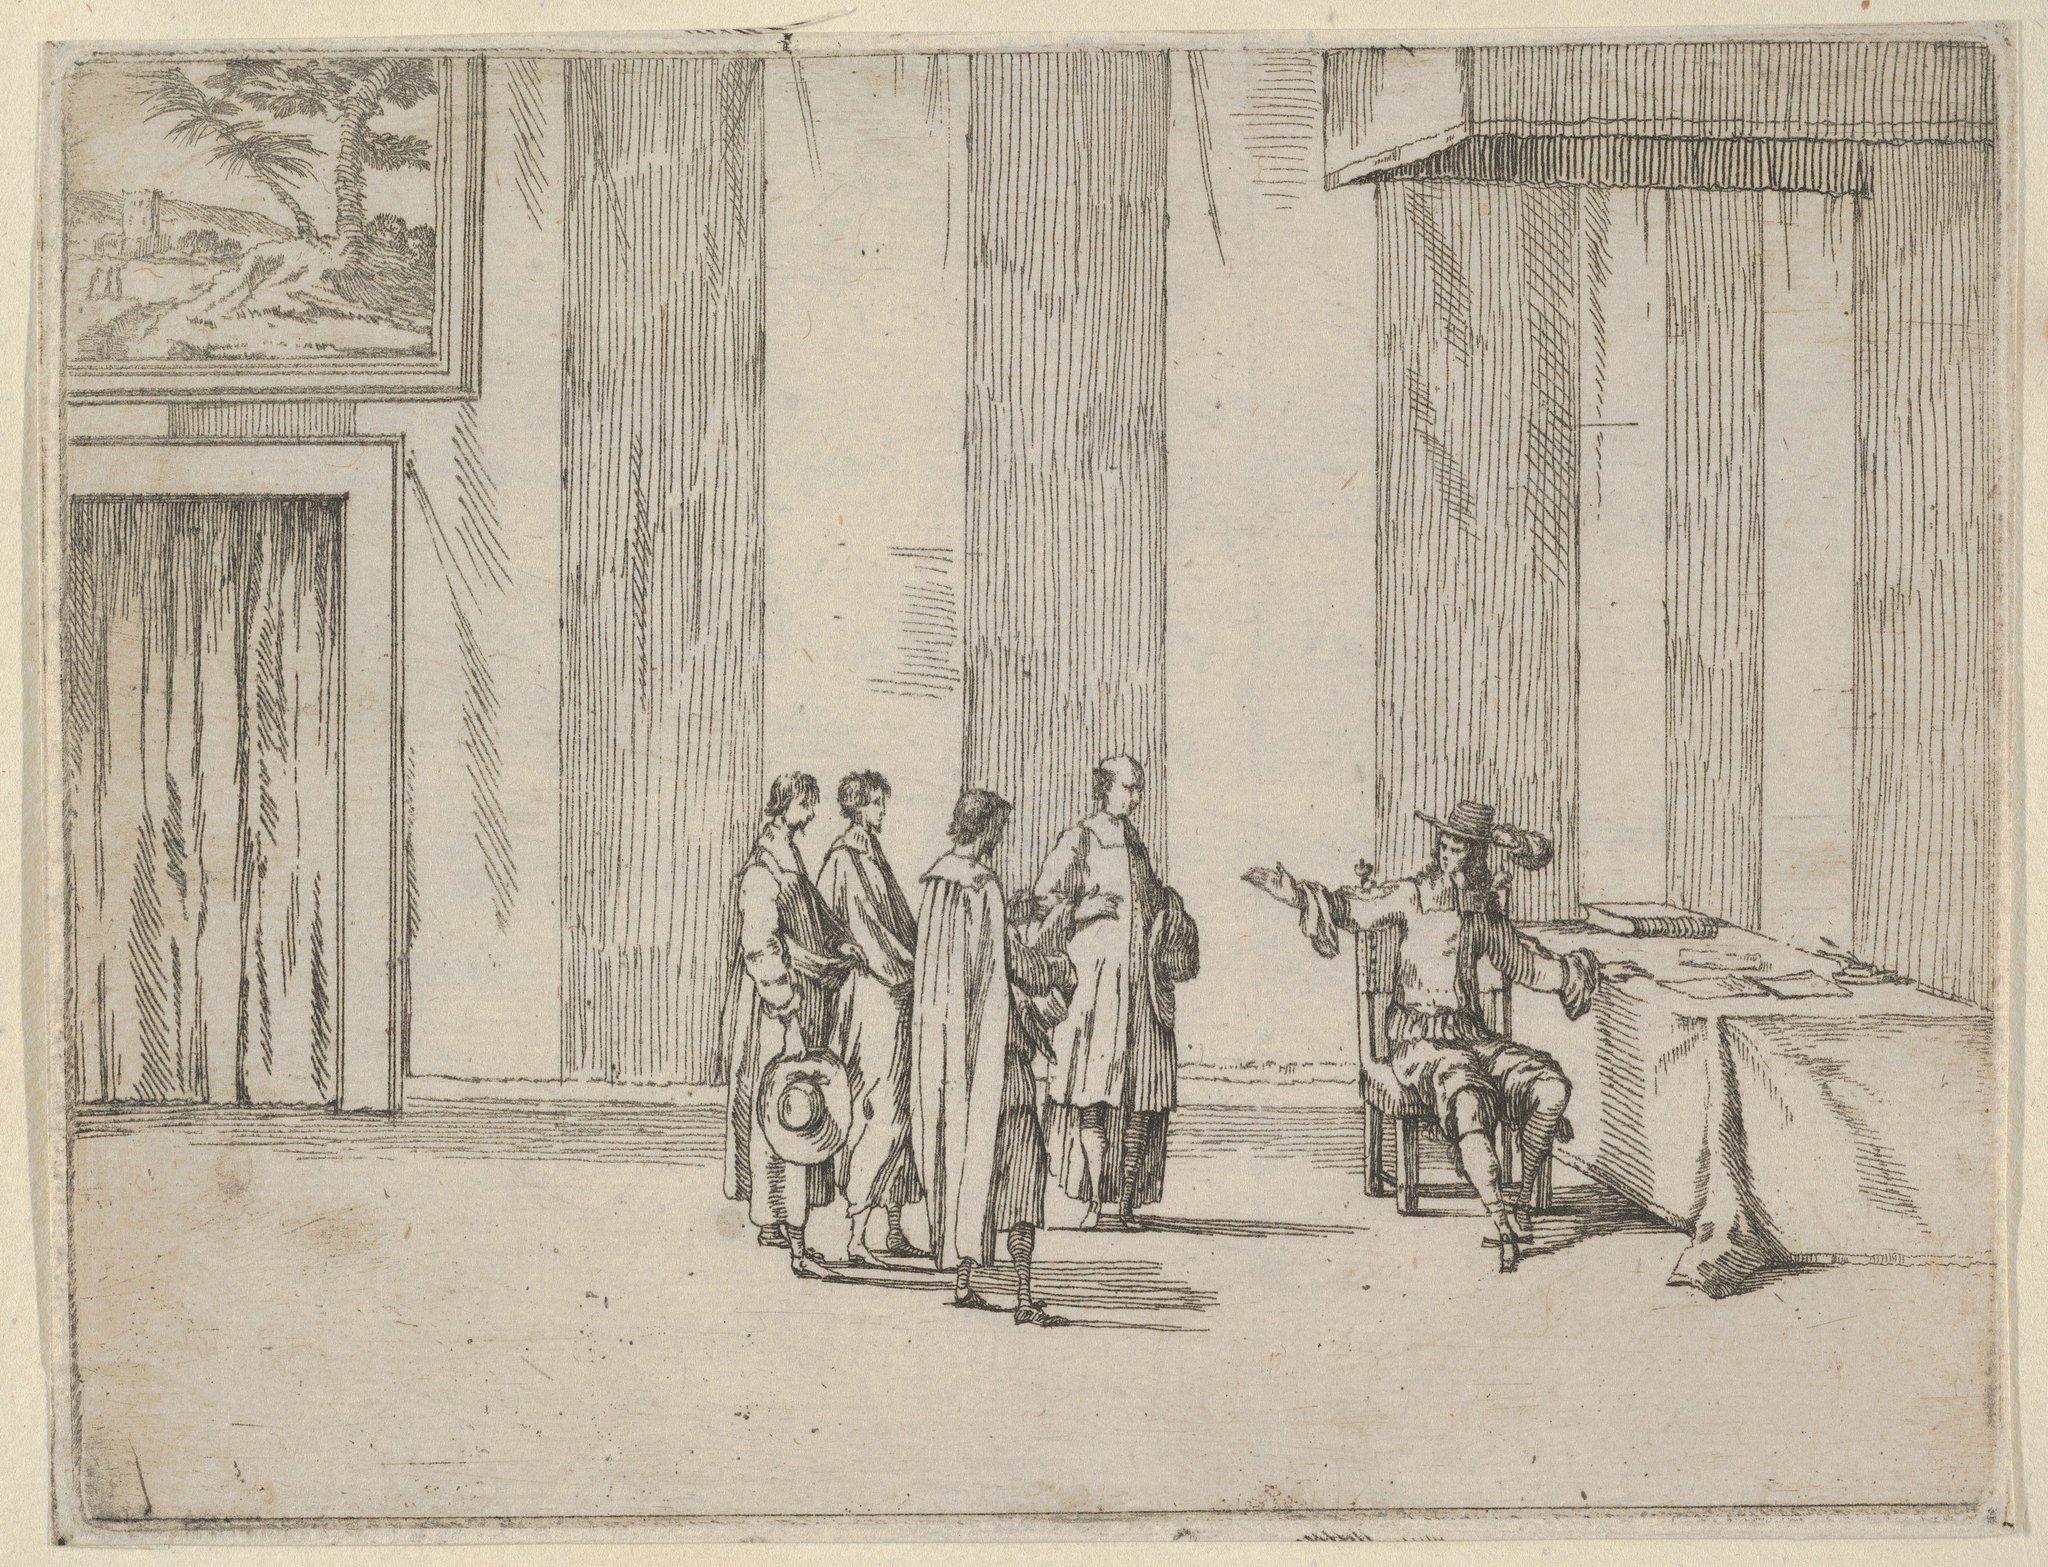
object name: print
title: Francesco I d'Este Takes Particular Care to Ensure that Justice is Observed, from "L'Idea di un Principe ed Eroe Cristiano in Francesco I d'Este, di Modena e Reggio Duca VIII [...]"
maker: bartolomeo fenice (fénis)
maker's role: artist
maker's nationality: italian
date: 1659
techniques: etching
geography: italy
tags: men